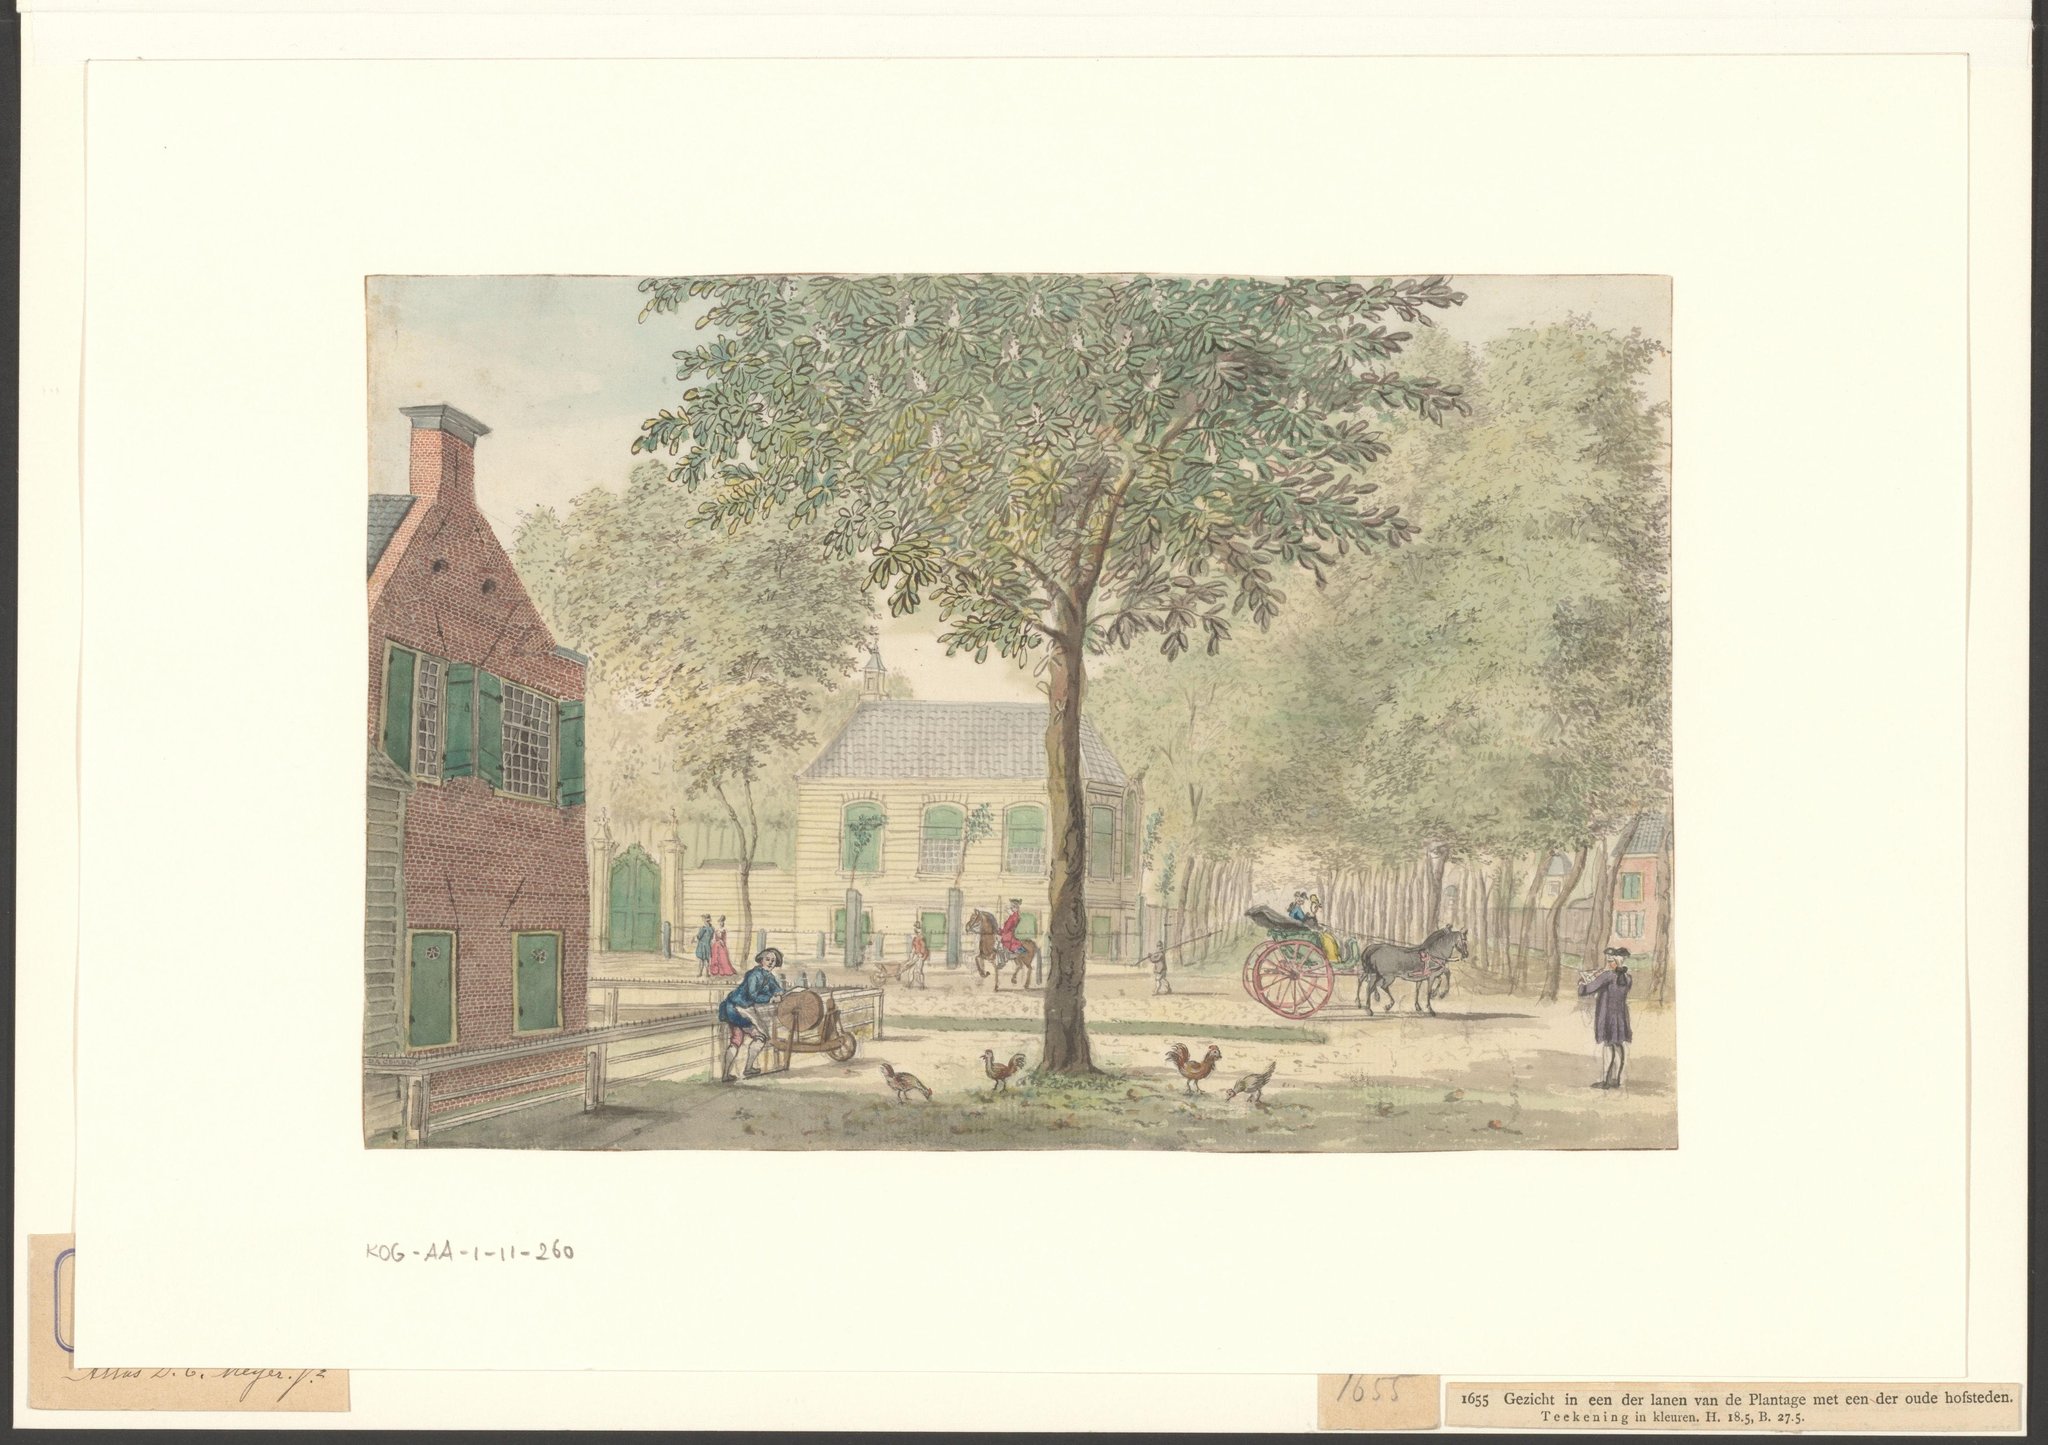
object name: drawing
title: Gezicht op een kruising in de Plantage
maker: Anonymous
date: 1750-1799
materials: paper, pencil, watercolor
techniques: brush, pen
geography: amsterdam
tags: city-view in general; 'veduta', street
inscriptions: collector's mark: ‘11’ Lugt 1641b, inscription: ‘Atlas D.C. Meijer (...) 18.5, B. 27.5.’, inscription: ‘Port. 11-260’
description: Onderwerpsrubriek binnen de Atlas Amsterdam: Paleisstraat, Palmgracht, Papenbrugsteeg, Passeerdersgracht, Peperstraat, Pieterspoort (St.), Pieterssteeg (St.), Plantage, Prinseneiland.